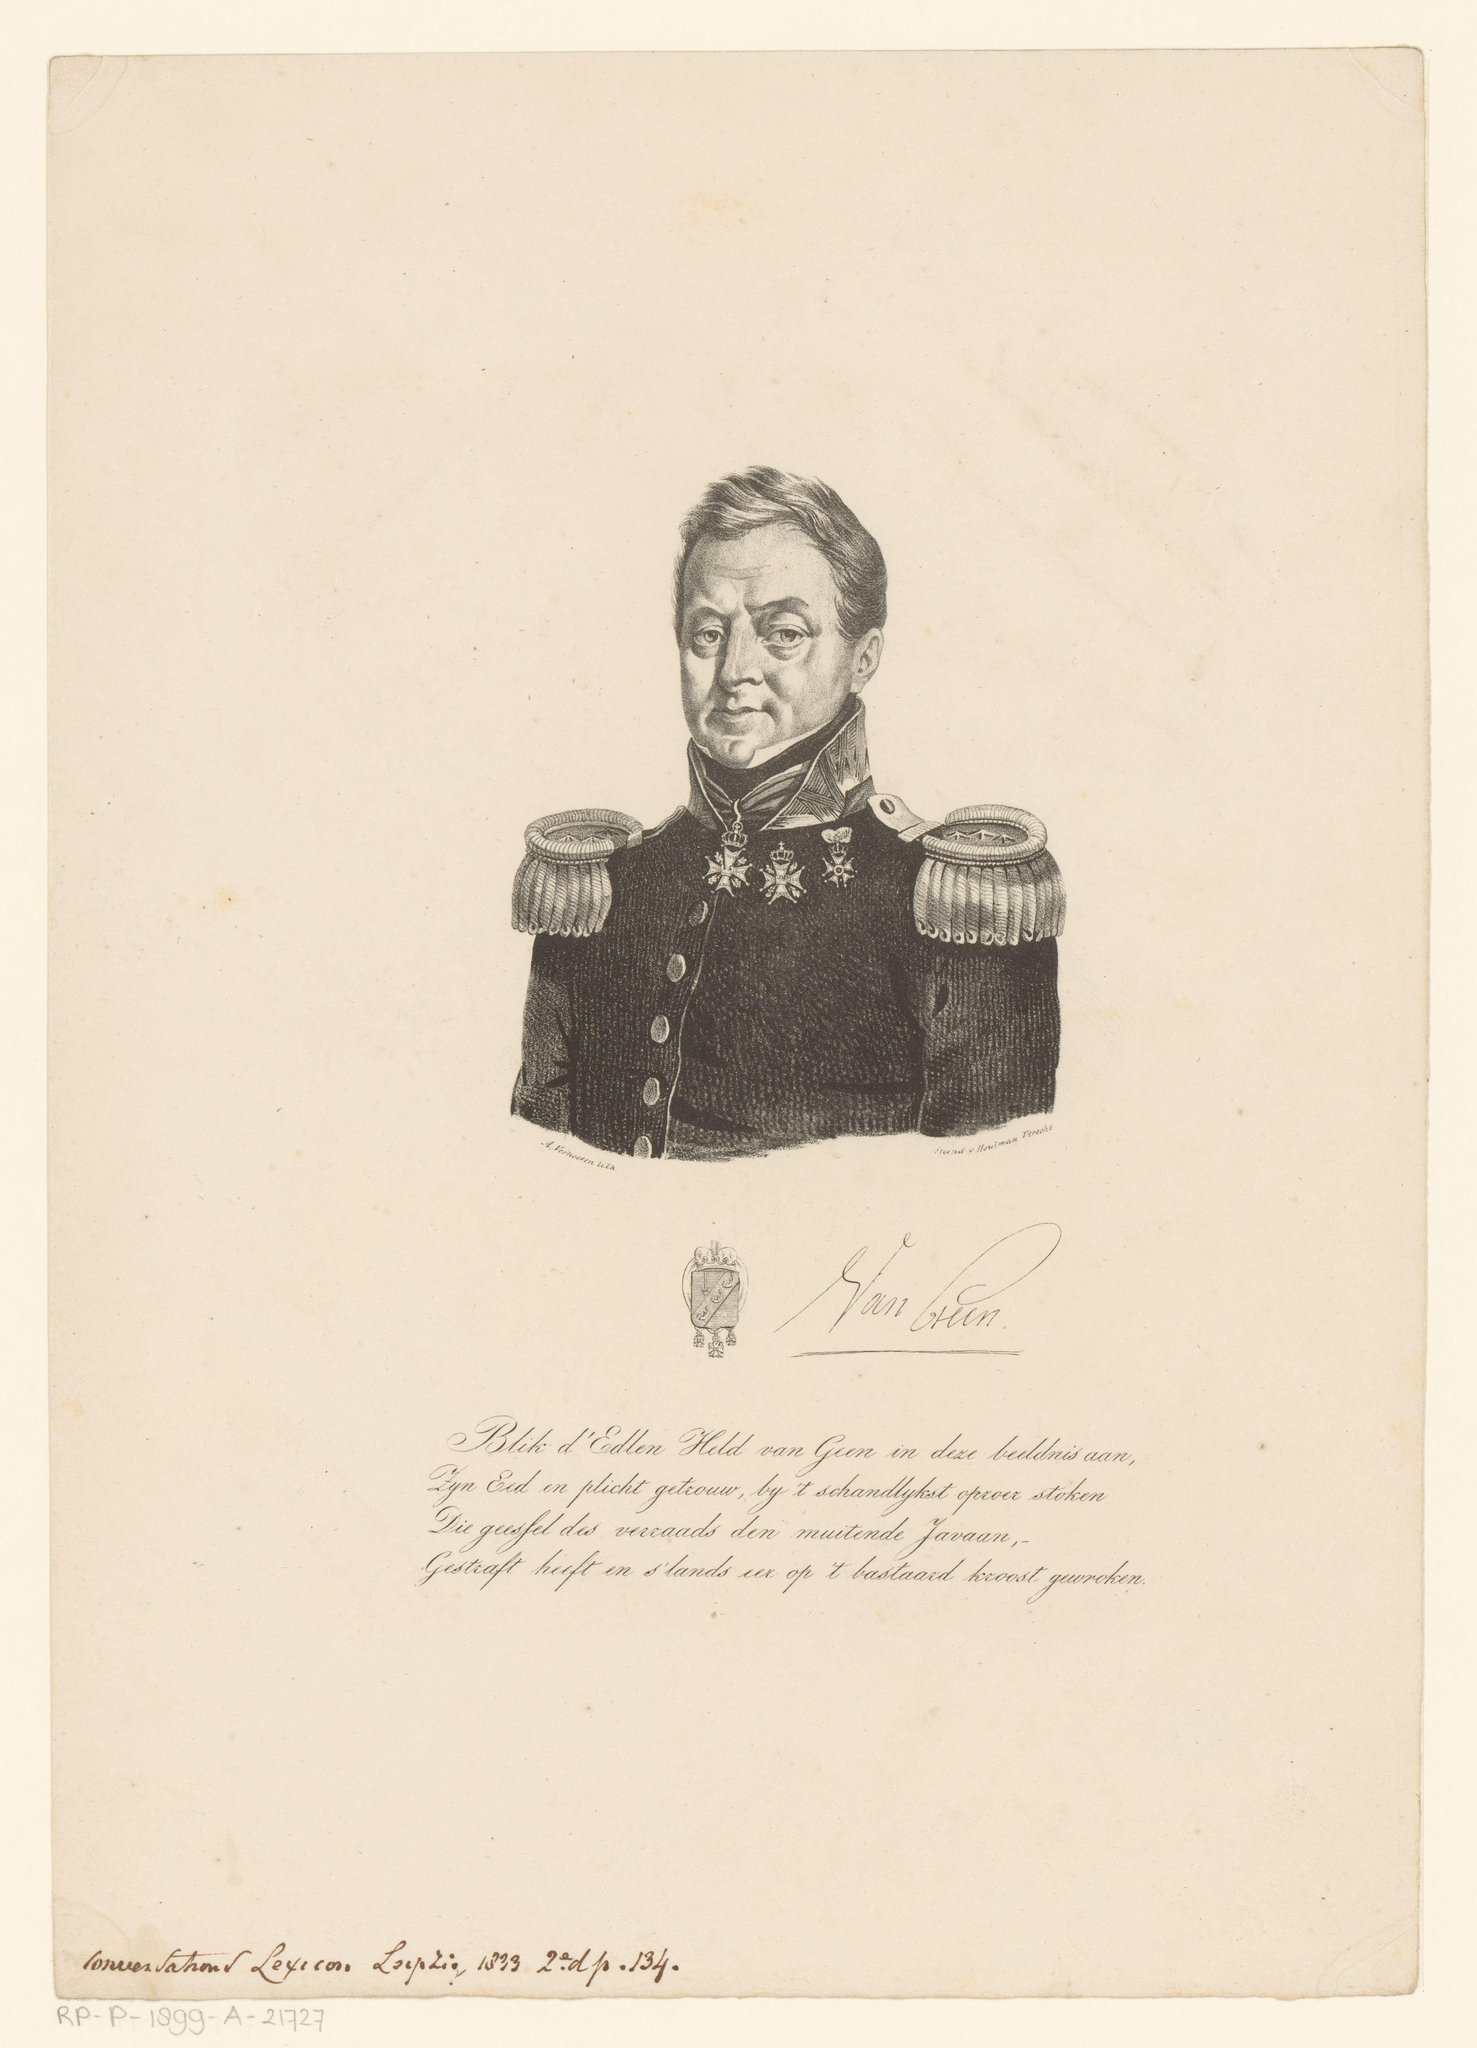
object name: print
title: Portret van Joseph Jacobus van Geen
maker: albertus verhoesen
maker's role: draughtsman, painter, print maker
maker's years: 1806-1881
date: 1828-1843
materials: paper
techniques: lithograph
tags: ghent, historical persons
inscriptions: collector's mark: Lugt 2228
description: Onder het portret de signatuur van de geportretteerde en een vierregelige vers.